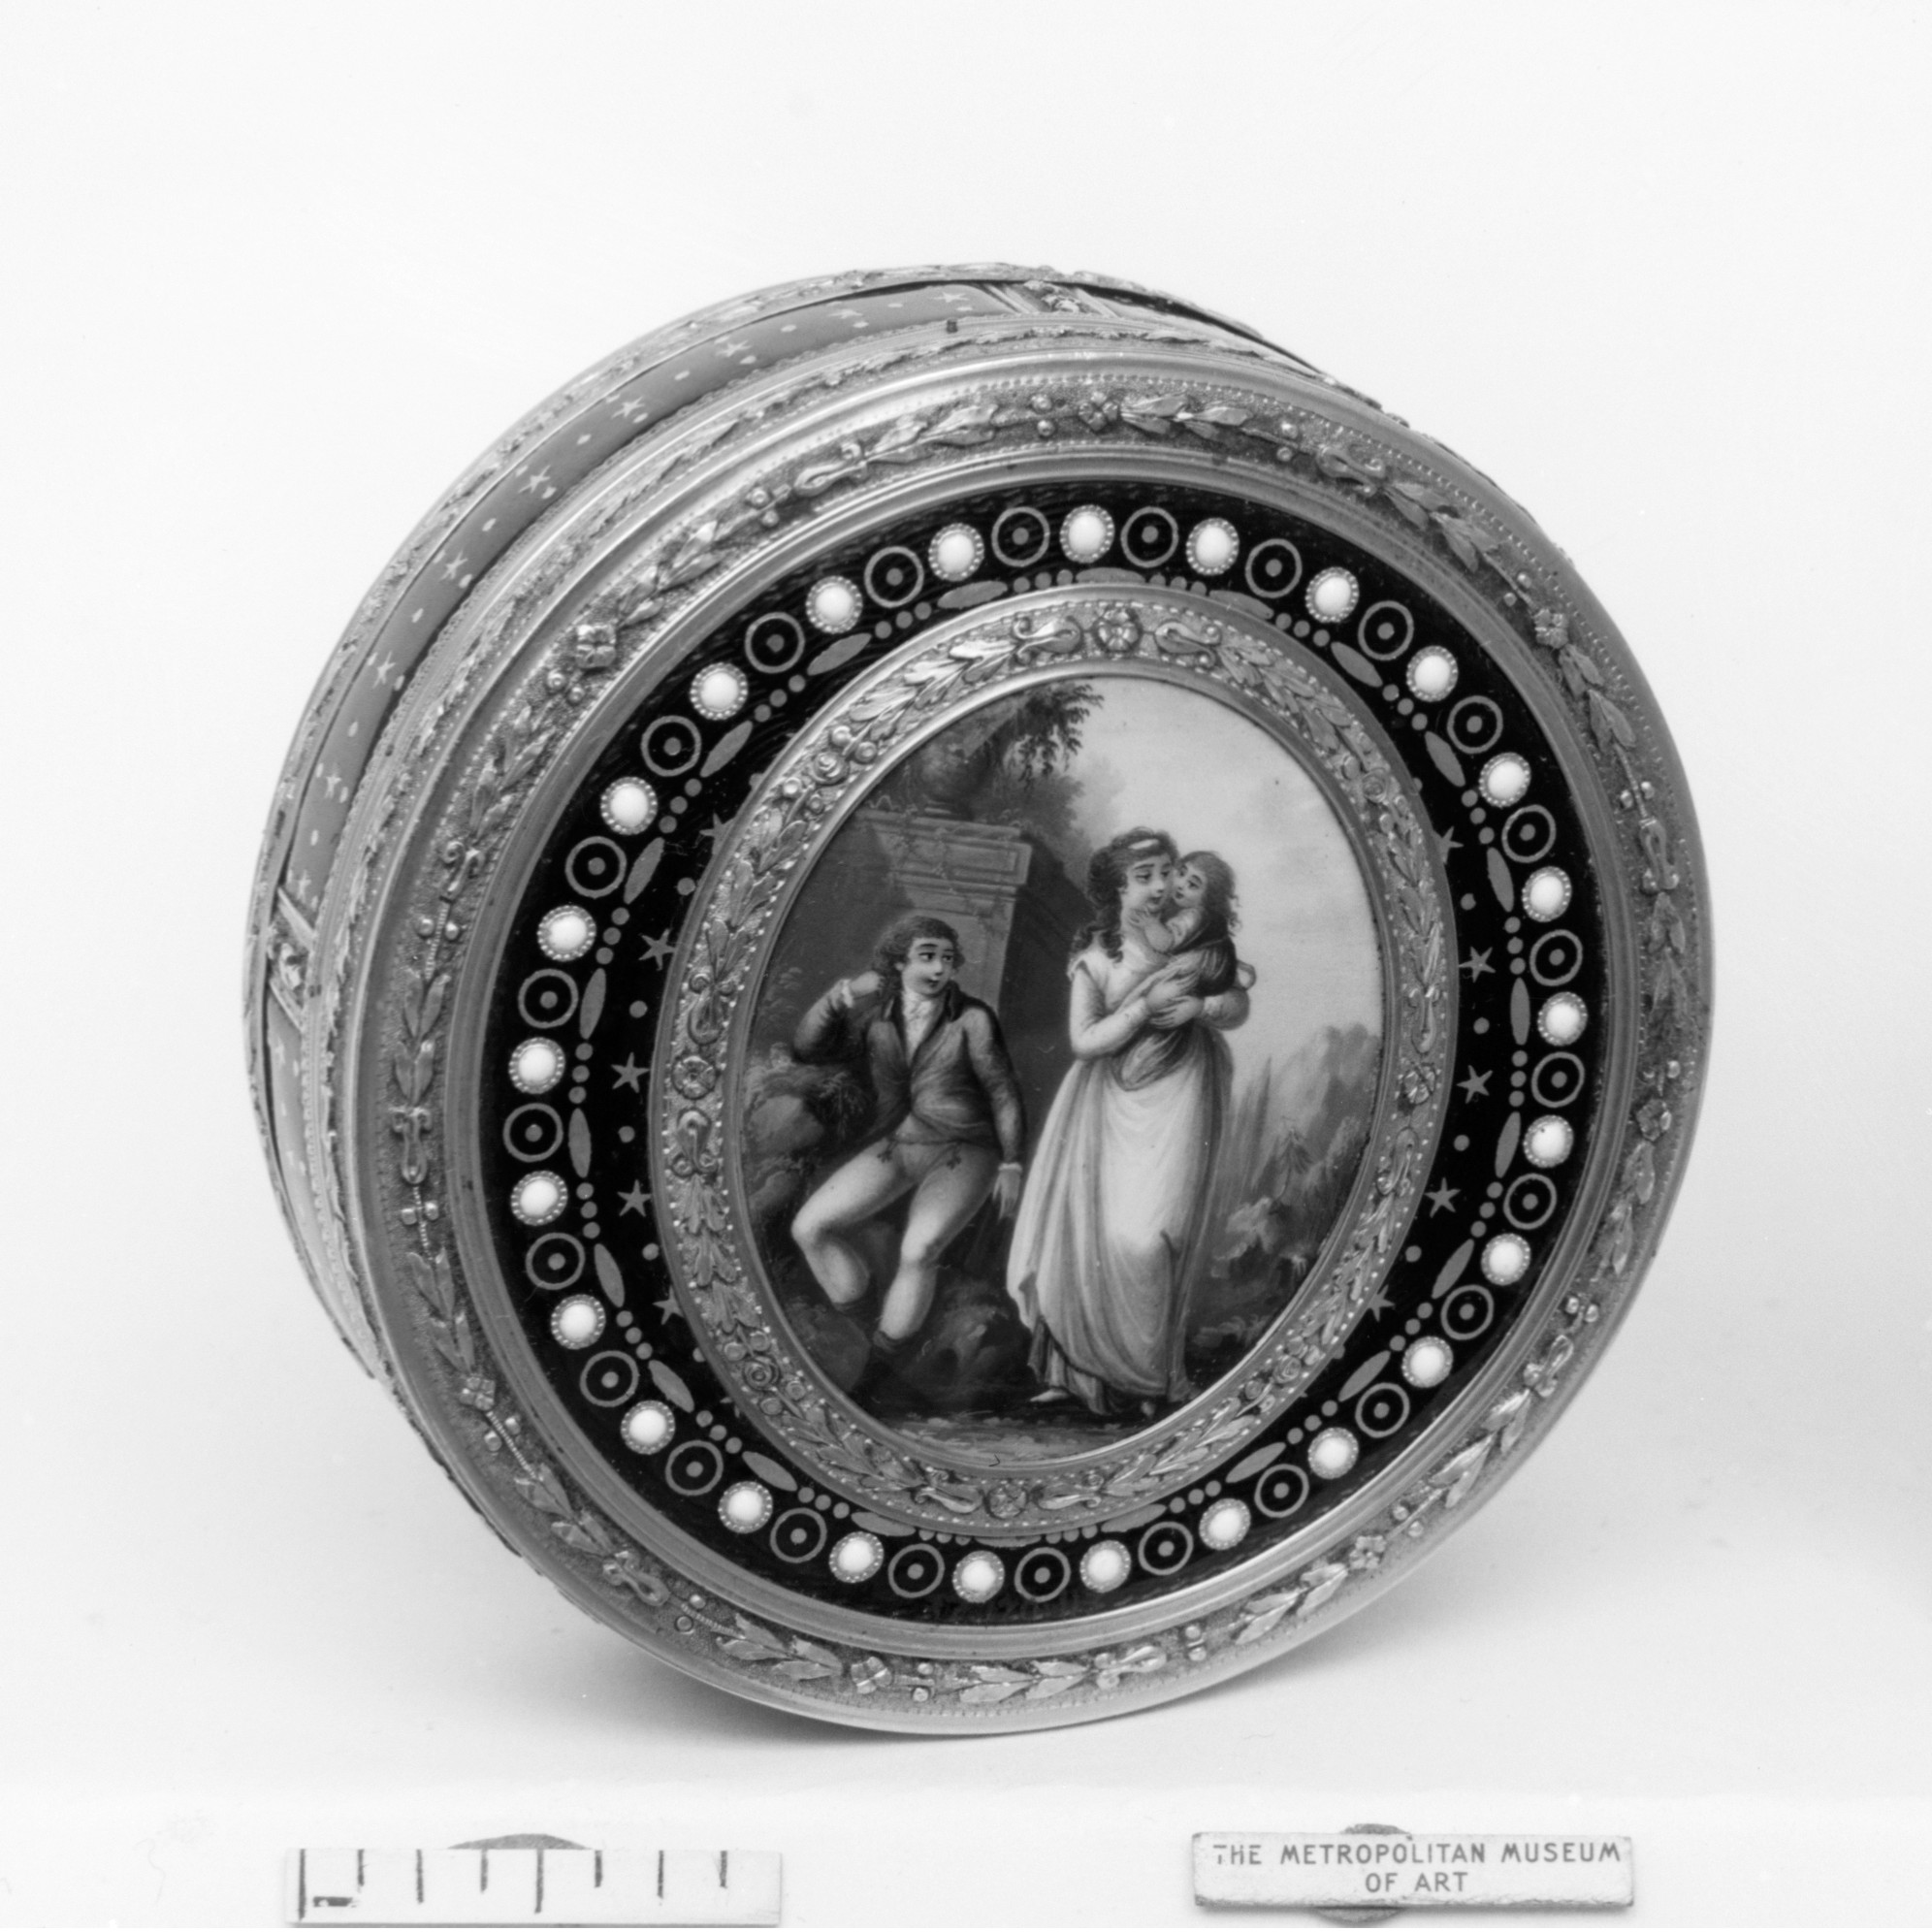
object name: snuffbox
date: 1701-1900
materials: enamel, gold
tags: infants,men,women